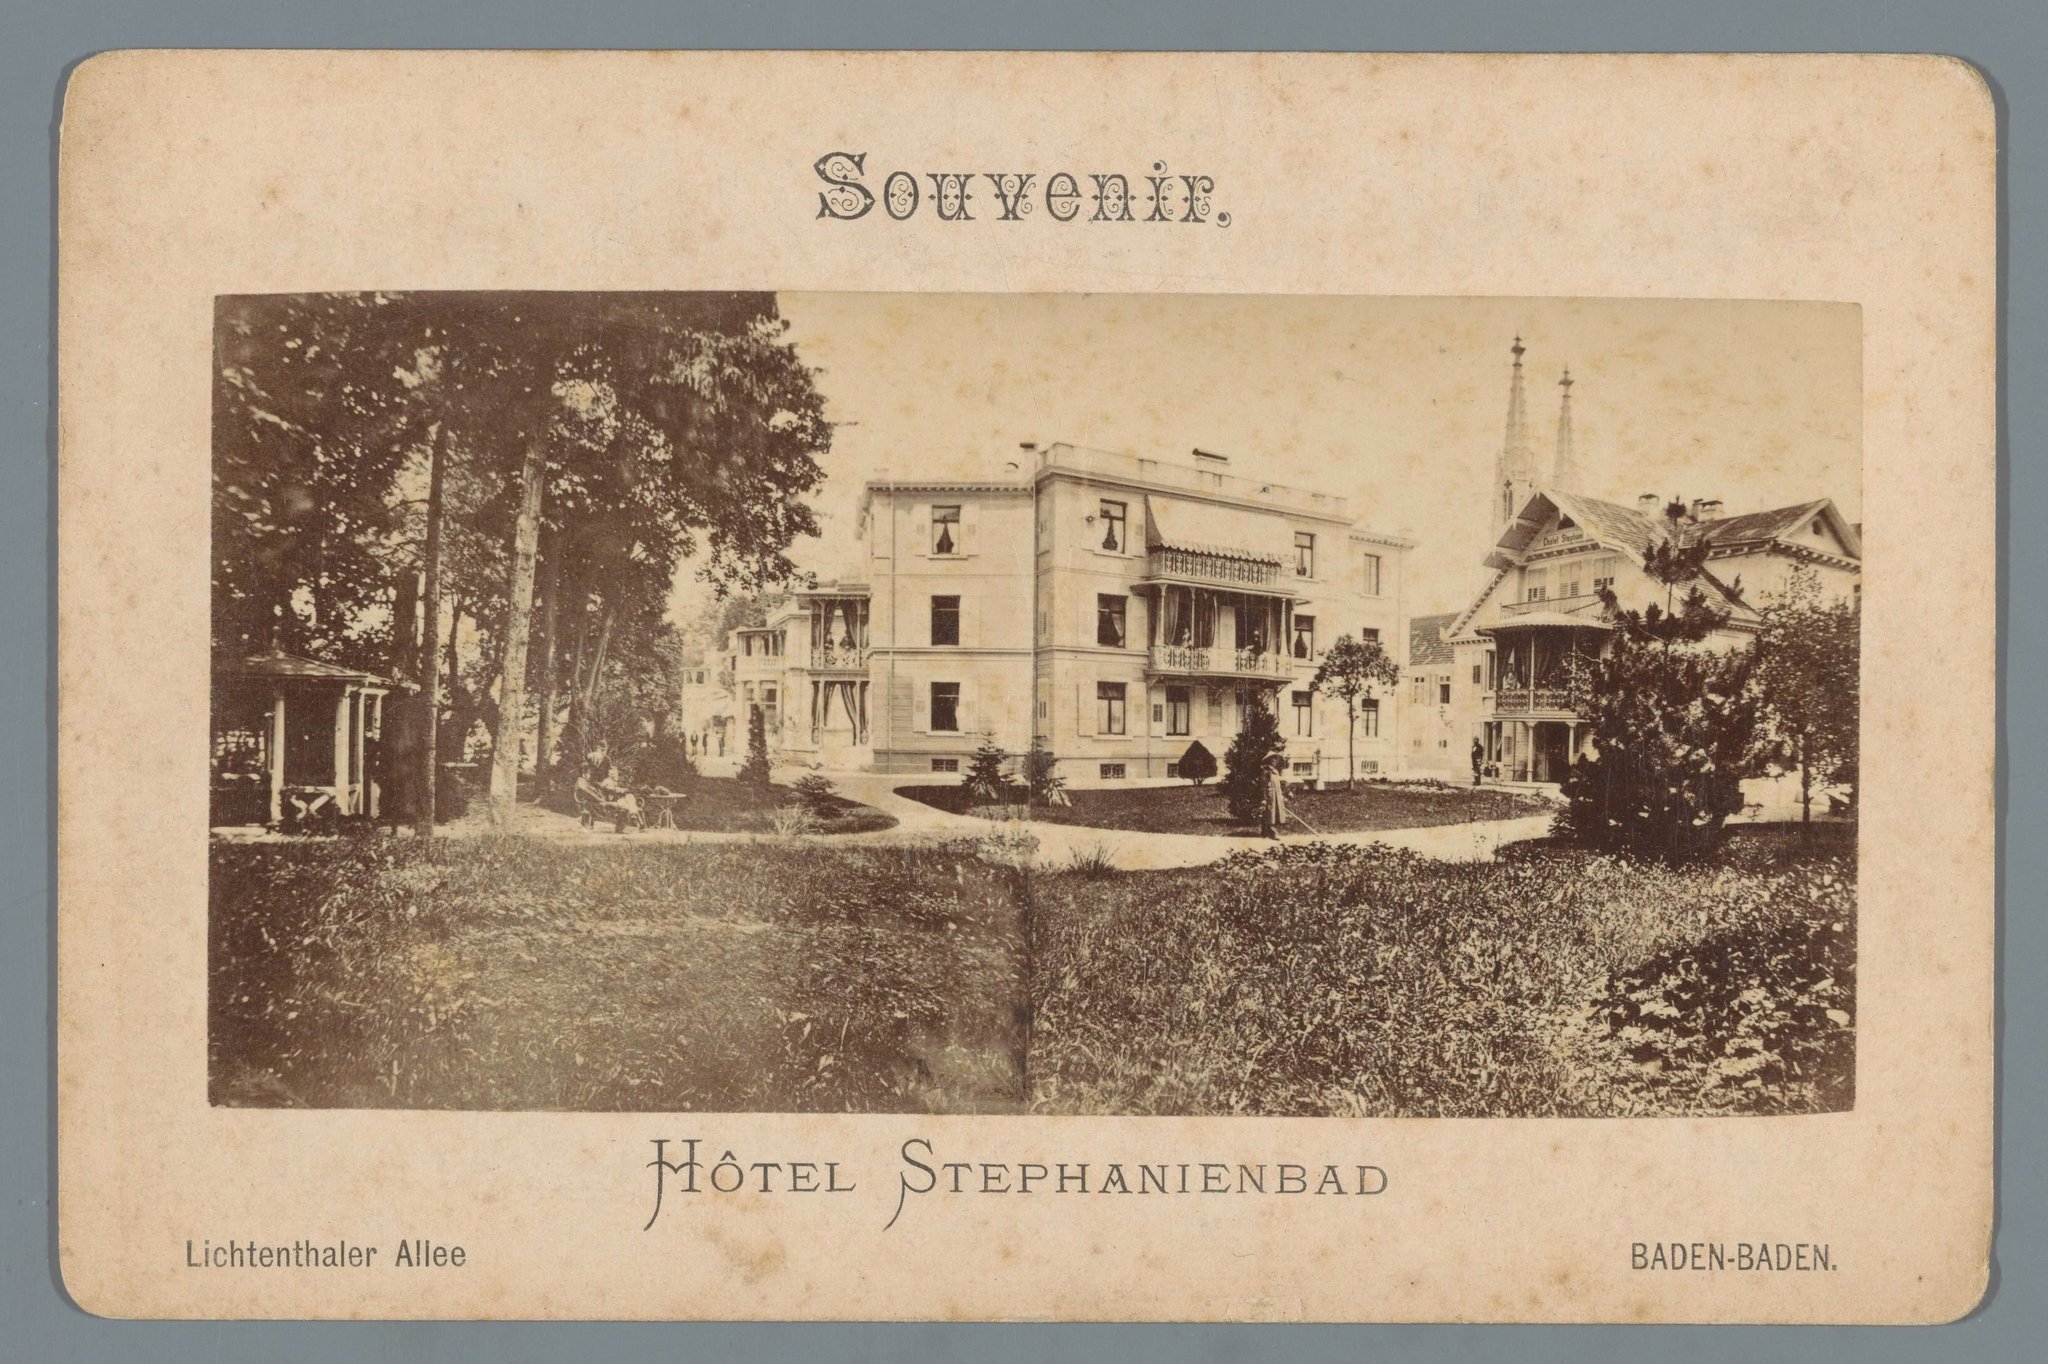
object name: photograph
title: Hôtel Stephanienbad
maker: hermann witte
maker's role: fotograaf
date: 1872-1900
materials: cardboard, photographic support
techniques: albumen print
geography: baden-baden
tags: façade (of house or building), hotel, hostelry, inn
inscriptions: workshop stamp: ‘Atelier für Photographie von Hermann Witte/ Schillerstrafse/ Baden-Baden./ (...)’, inscription: ‘Souvenir./ Lichtenthaler Allee/ Baden-Baden.’